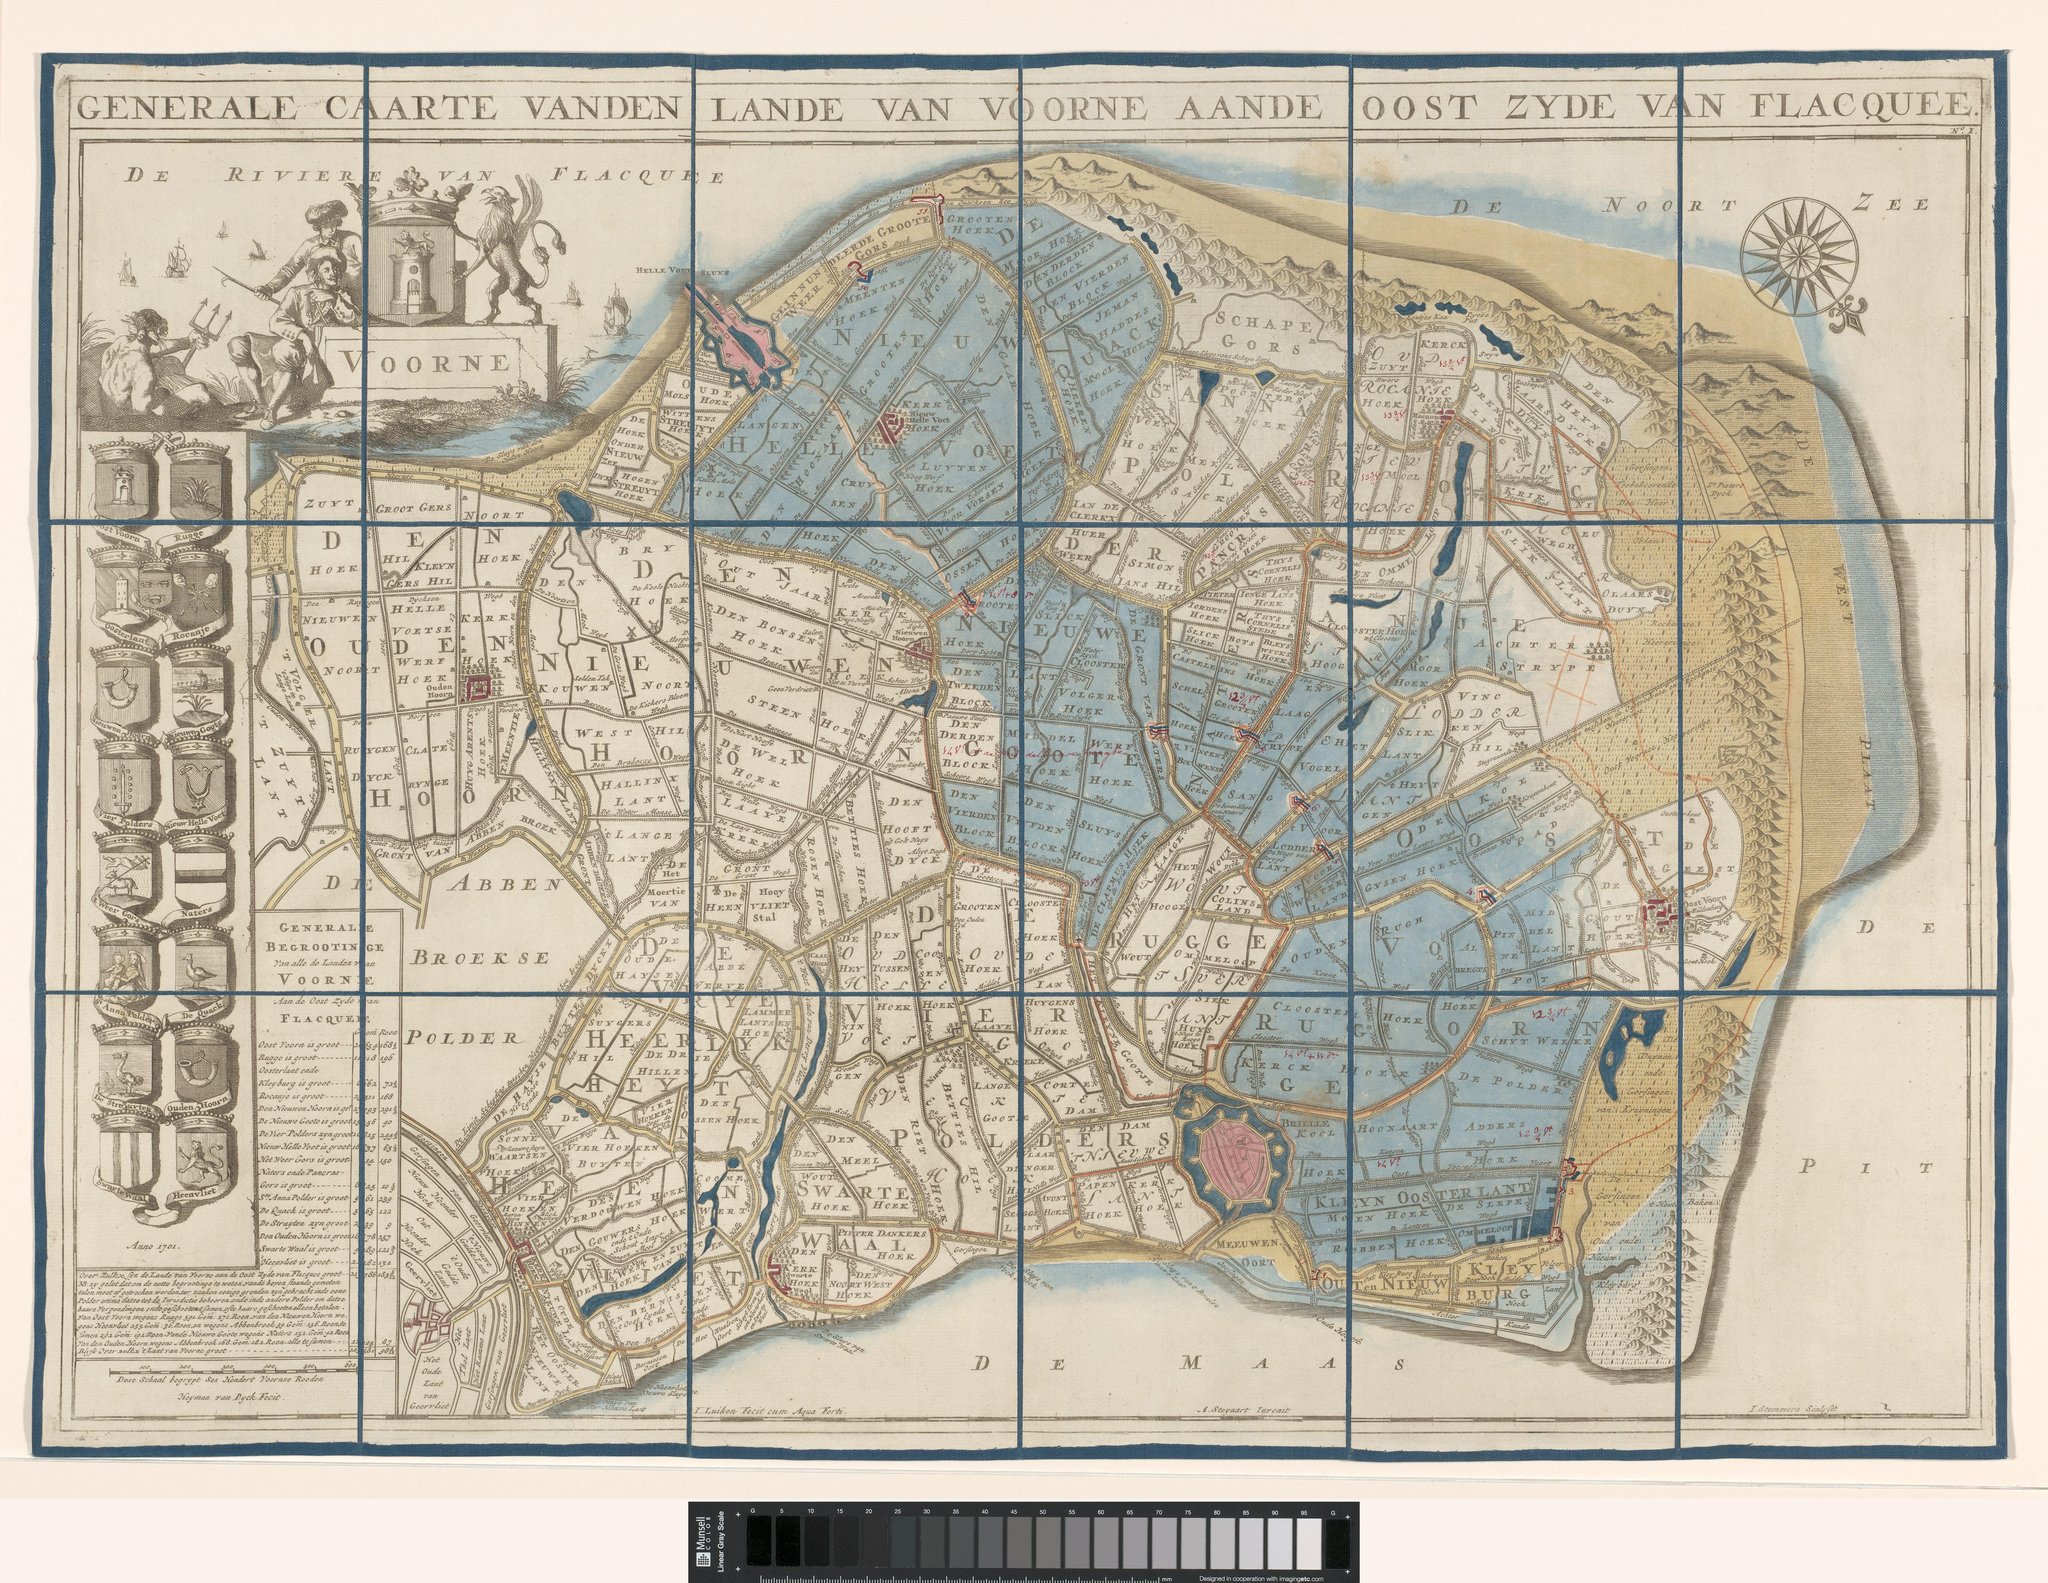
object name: print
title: Voorne Caart-boeck / Caartboeck van Voorne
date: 1701-1729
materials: ink, linen, paper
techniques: brush, engraving, etching, pen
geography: amsterdam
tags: coat of arms (as symbol of the state, etc.), maps of separate countries or regions, river-gods, fisherman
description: Deze kaart is onderdeel van het zogenaamde 'Voorne Caart-boeck' / 'Caartboeck van Voorne', dat bestaat uit een titelpagina (zie RP-P-1942-347), drie algemene kaarten (van Oost-, West- en Zuid-Voorne)* en dertig detailkaarten. Het kaartboek werd vervaardigd in opdracht van de Staten van Voorne en werd in 1701 uitgegeven. Een deel van de koperplaten is bewaard gebleven en in de negentiende en twintigste eeuw gebruikt voor herdrukken. *Over de naam Voorne kan verwarring ontstaan omdat de betekenis door de eeuwen heen is veranderd. Vroeger stonden de (voormalige) eilanden Voorne, Goeree en Overflakkee – allen historisch gezien onderdeel van het Land van Voorne – bekend als respectievelijk Oost-, West- en Zuid-Voorne. Afdrukken van de drie algemene kaarten, waaronder deze kaart, zijn ook gebruikt in: Alkemade, Cornelis van en Pieter van der Schelling. Beschryving van de Stad Brielle, en den lande van Voorn (…). Rotterdam: Philippus Losel, 1729.